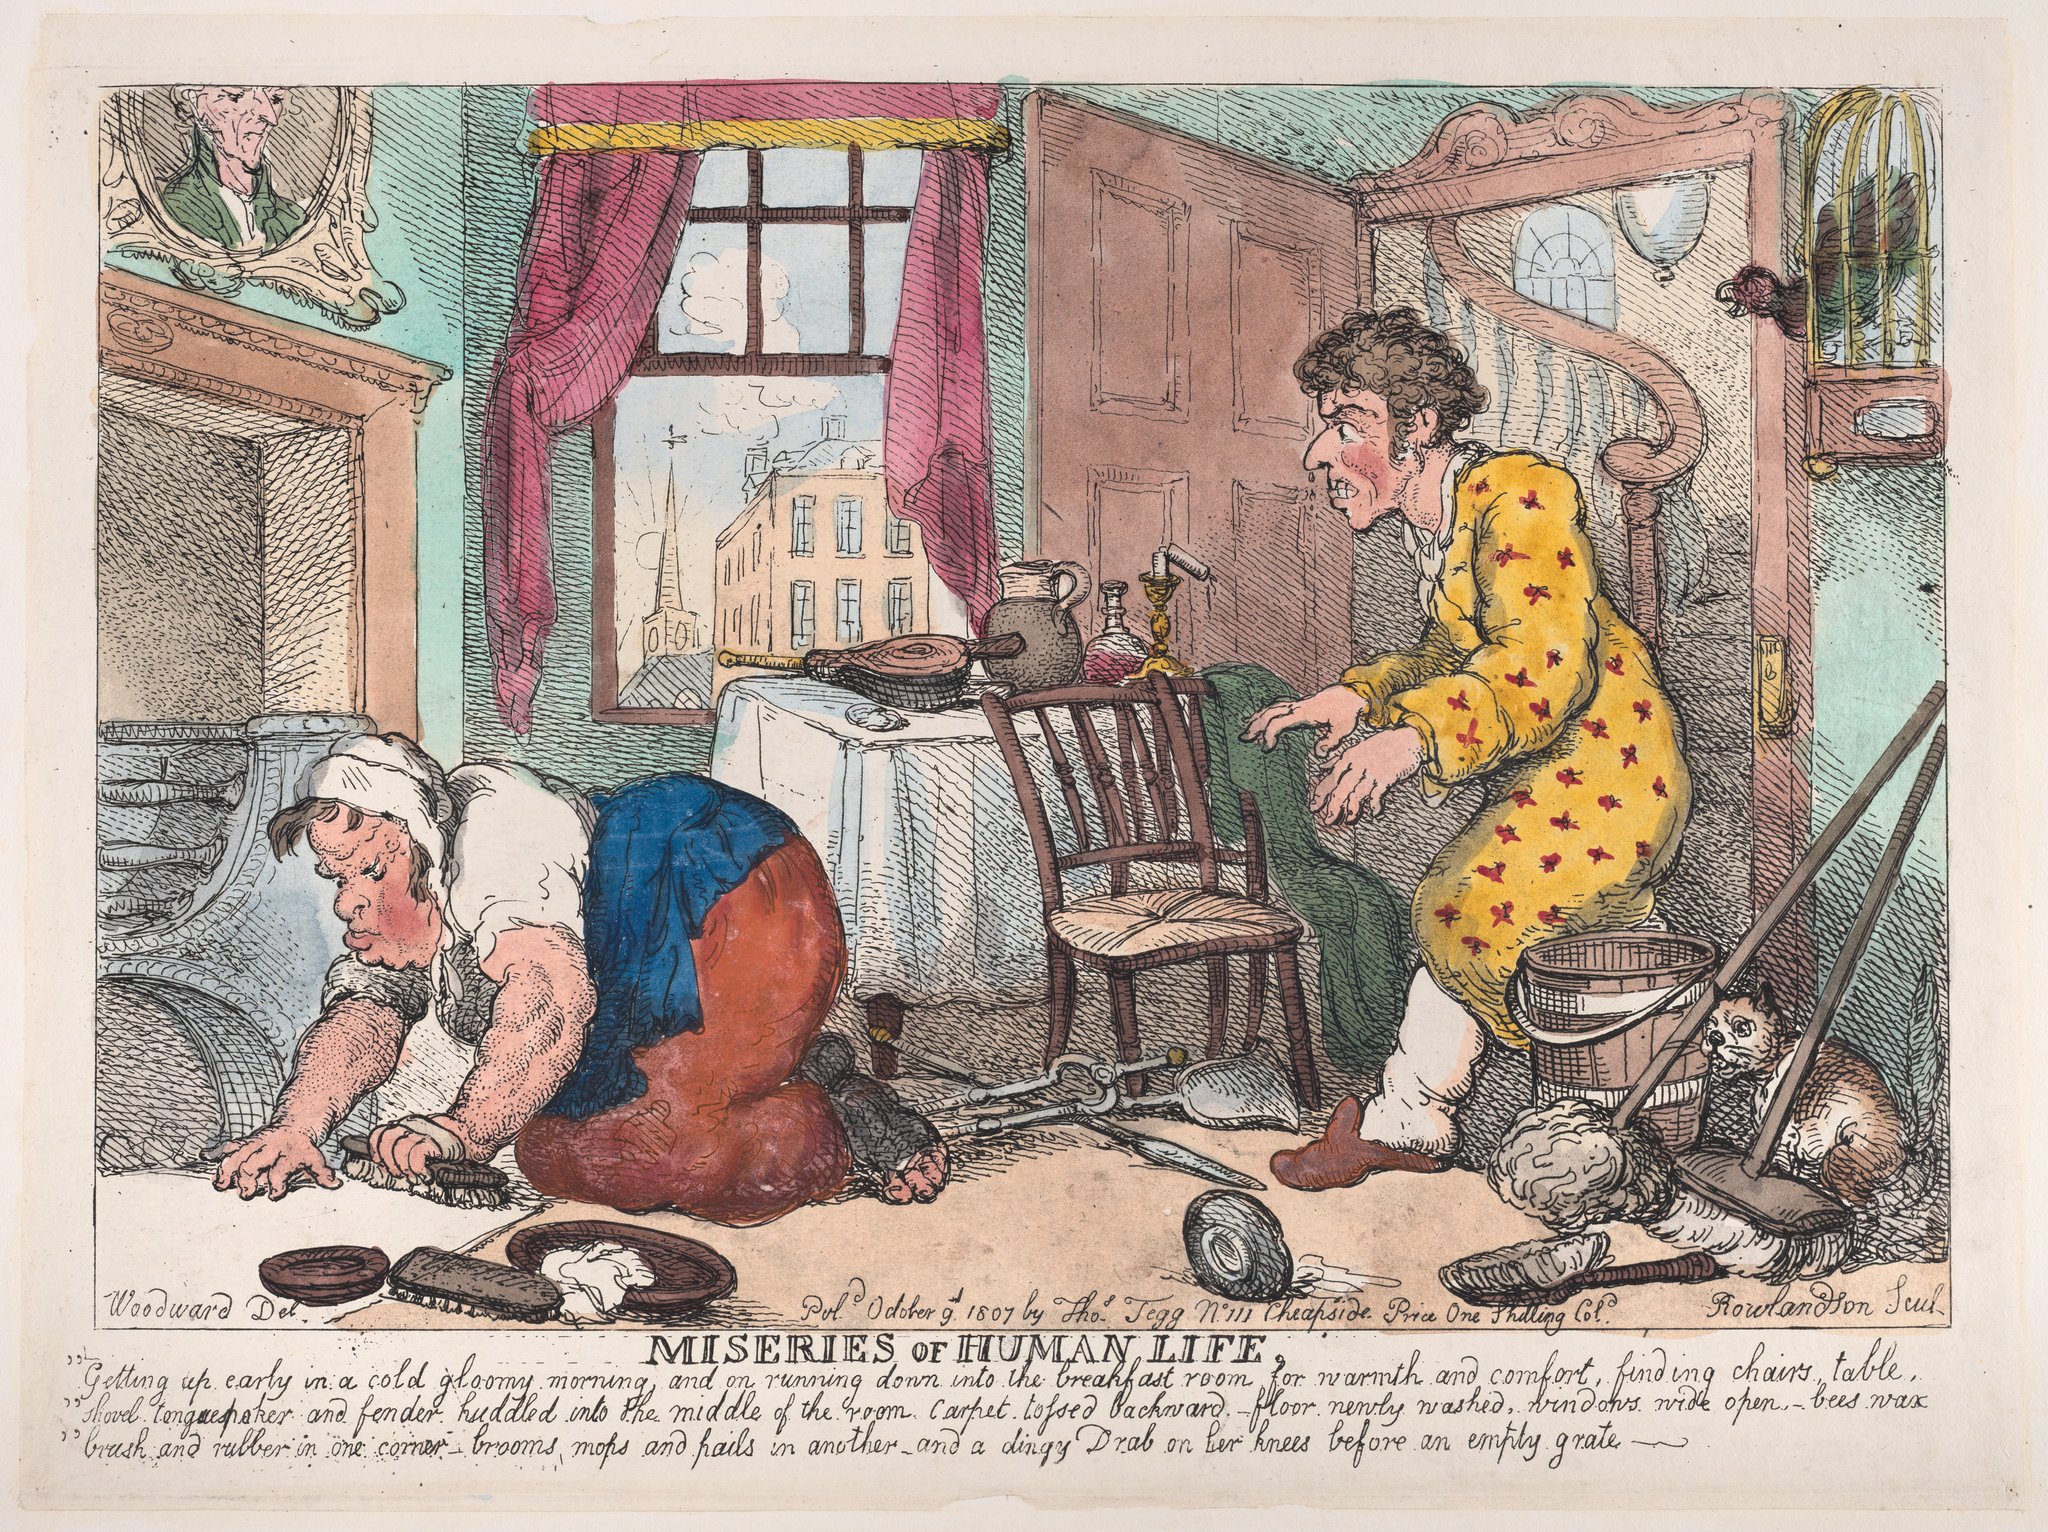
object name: print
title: The Miseries of Human Life: Getting Up Early in a Cold Gloomy Morning...Before an Empty Grate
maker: thomas rowlandson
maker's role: artist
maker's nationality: british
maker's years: 1757-1827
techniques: etching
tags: satire,men,women,cats